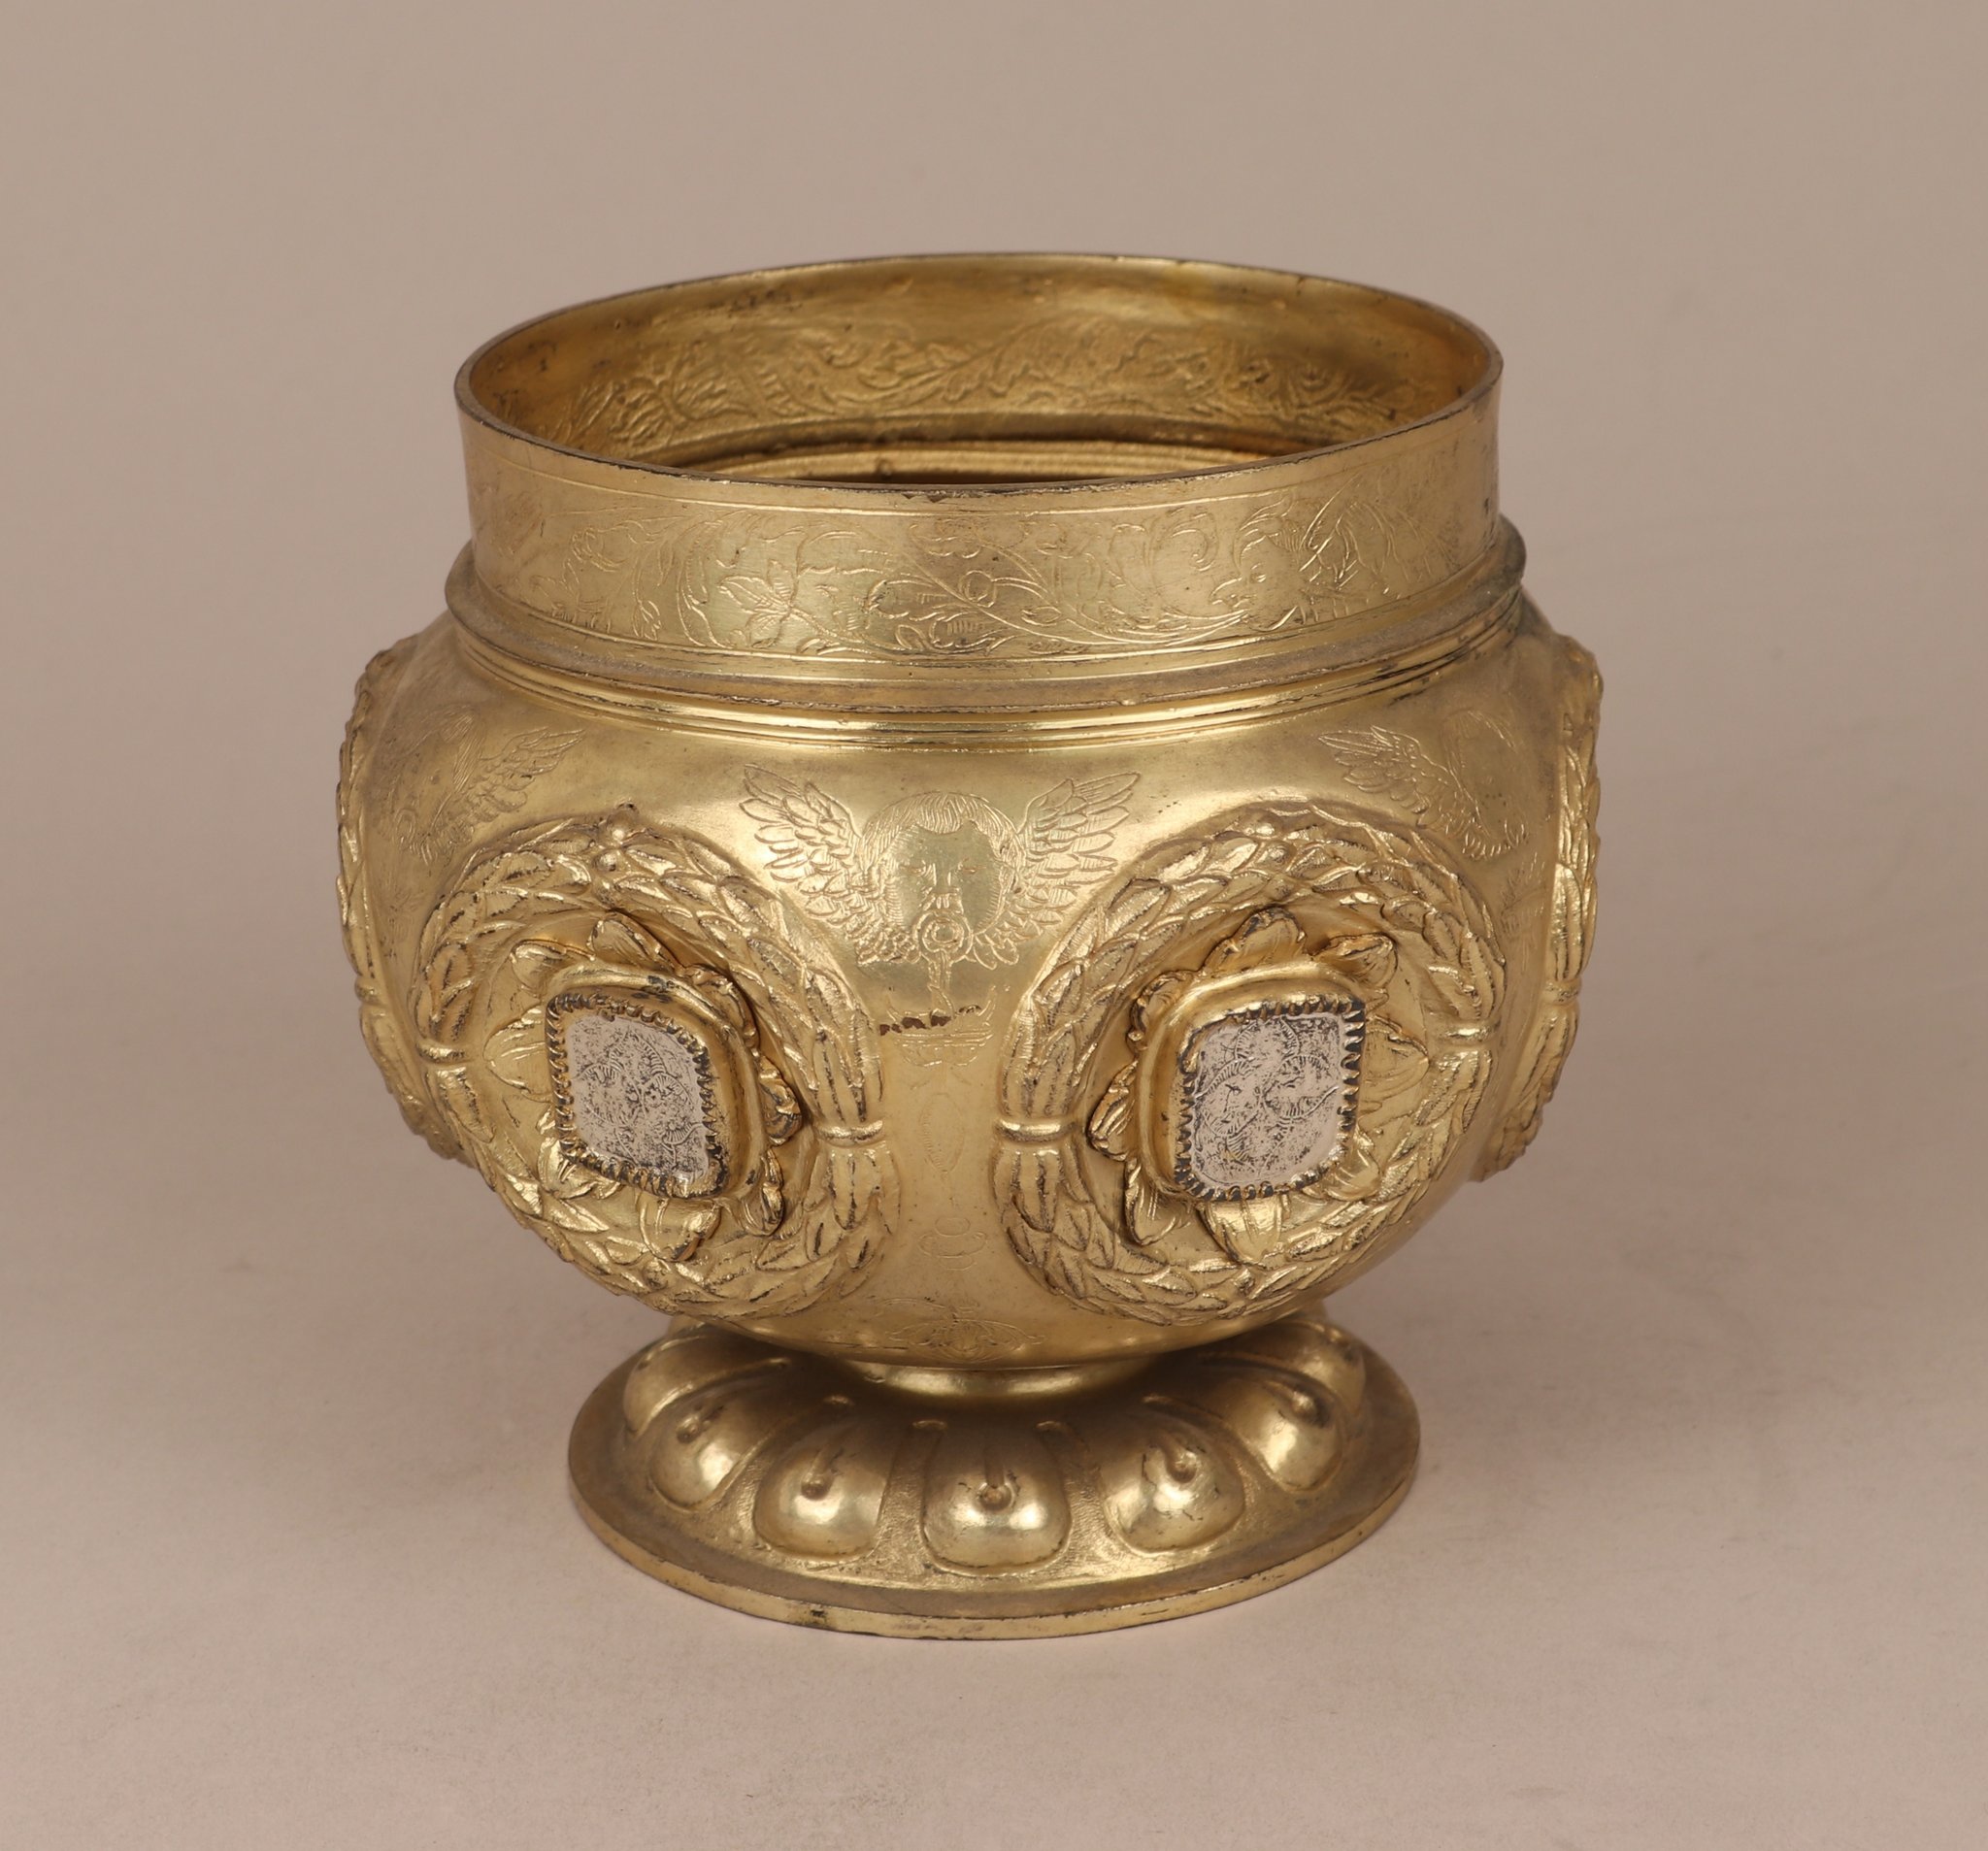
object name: bratina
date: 1801-1900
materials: metal, silver